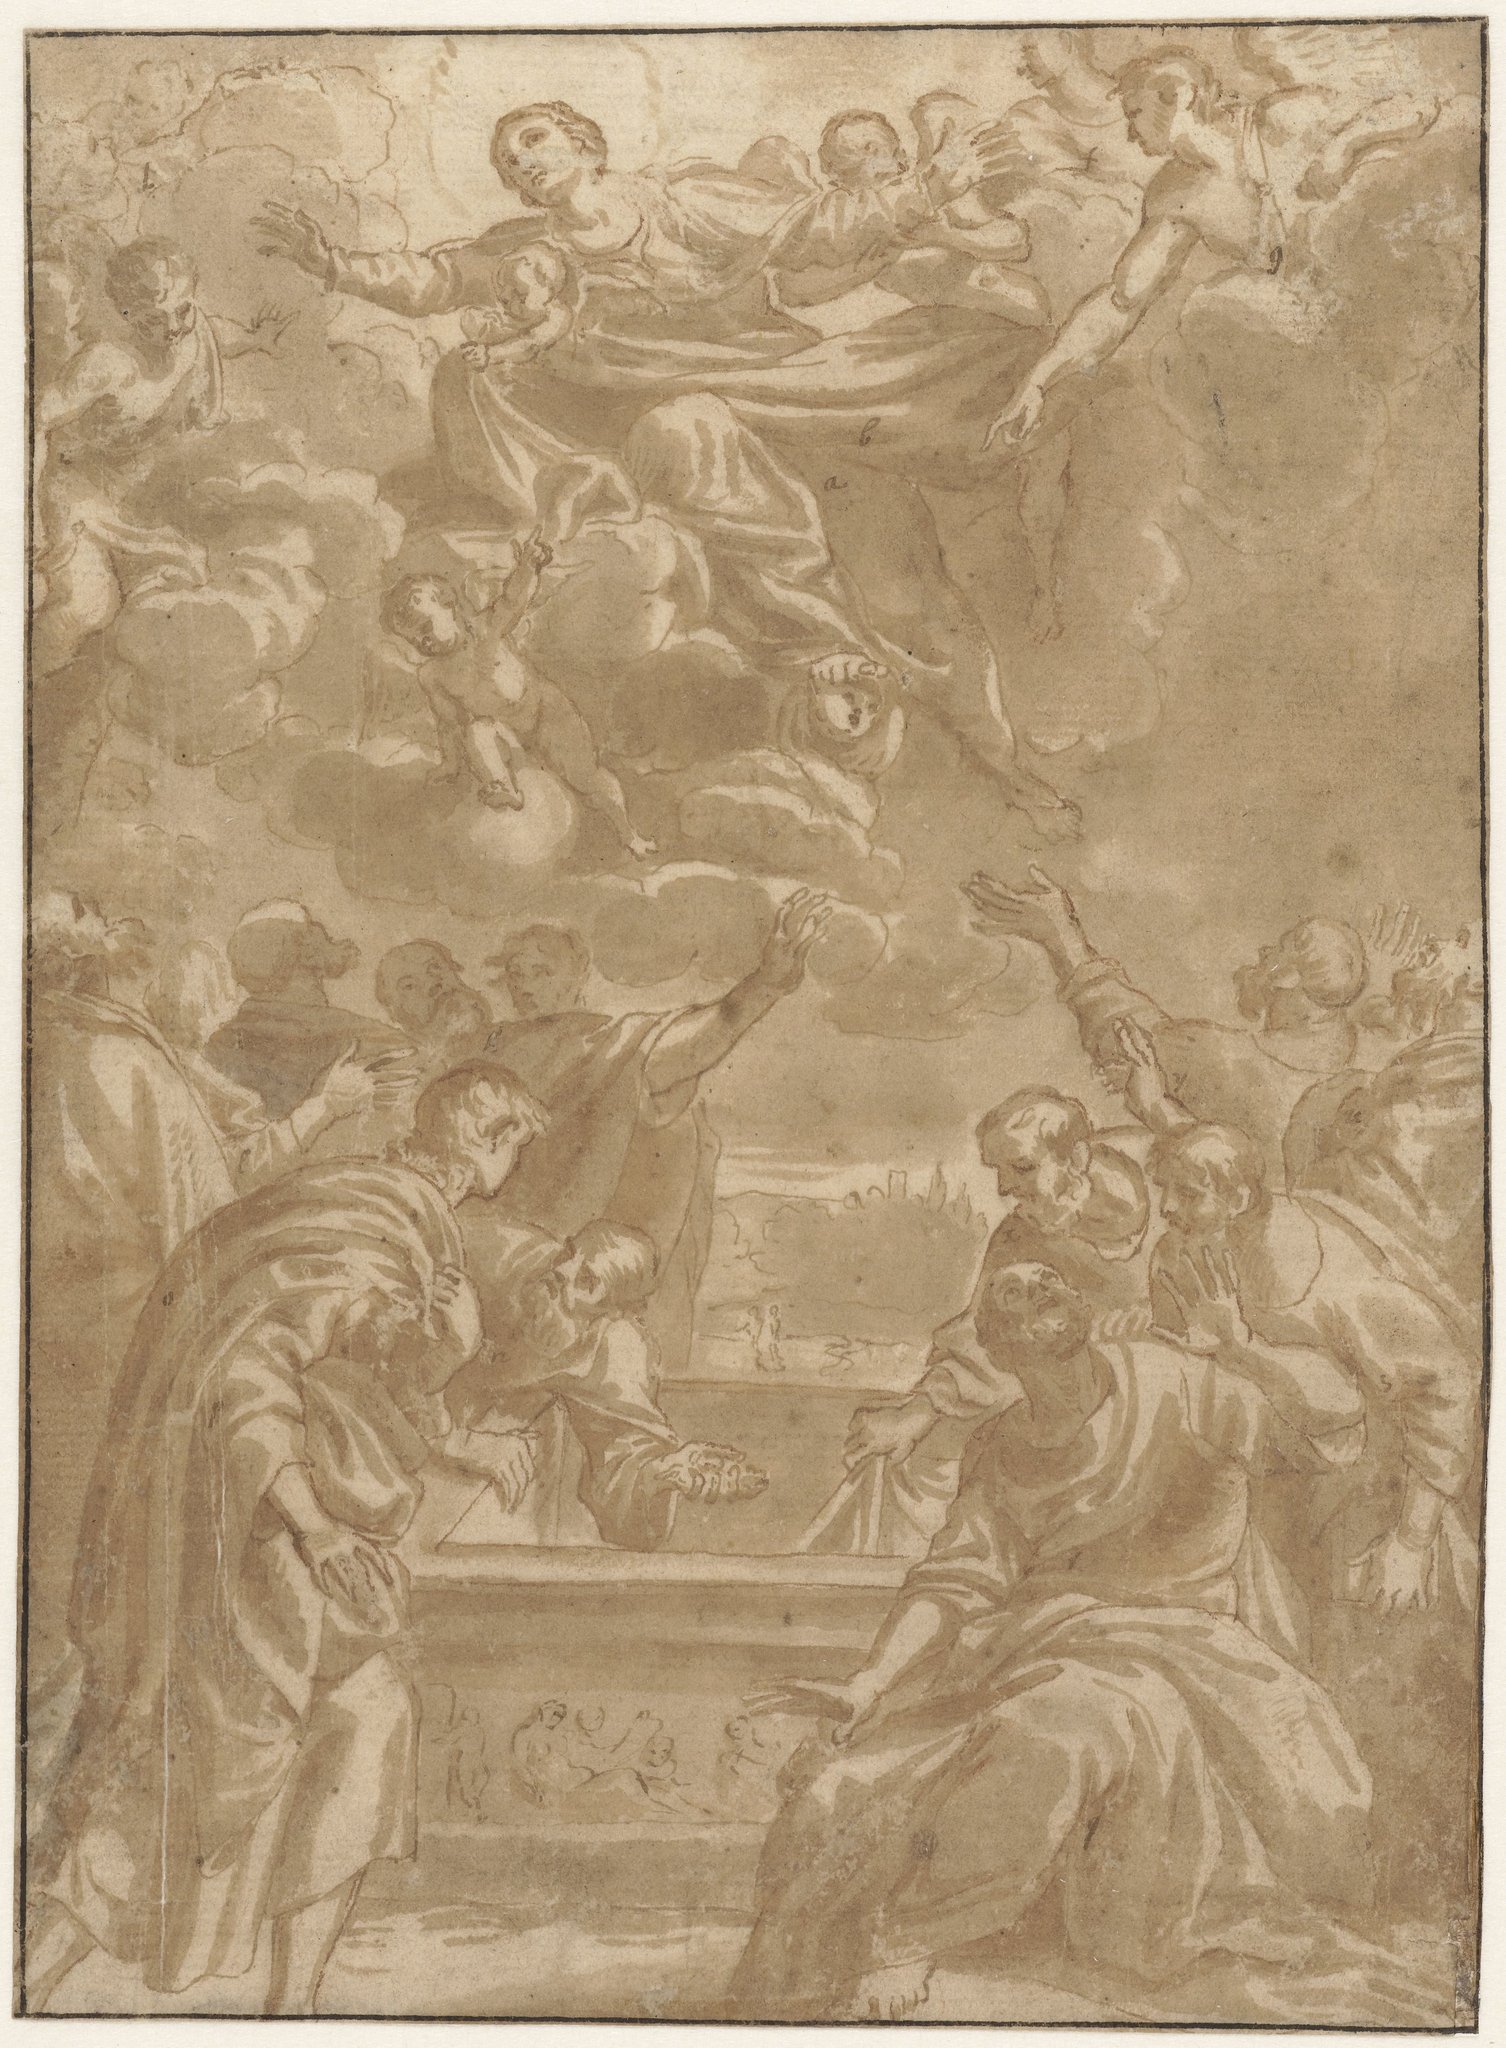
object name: drawing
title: Hemelvaart van Maria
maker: Anonymous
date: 1592-1620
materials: ink, paper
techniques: brush, pen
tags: the assumption of mary ('assumptio corporis'): she is borne into heaven by angels